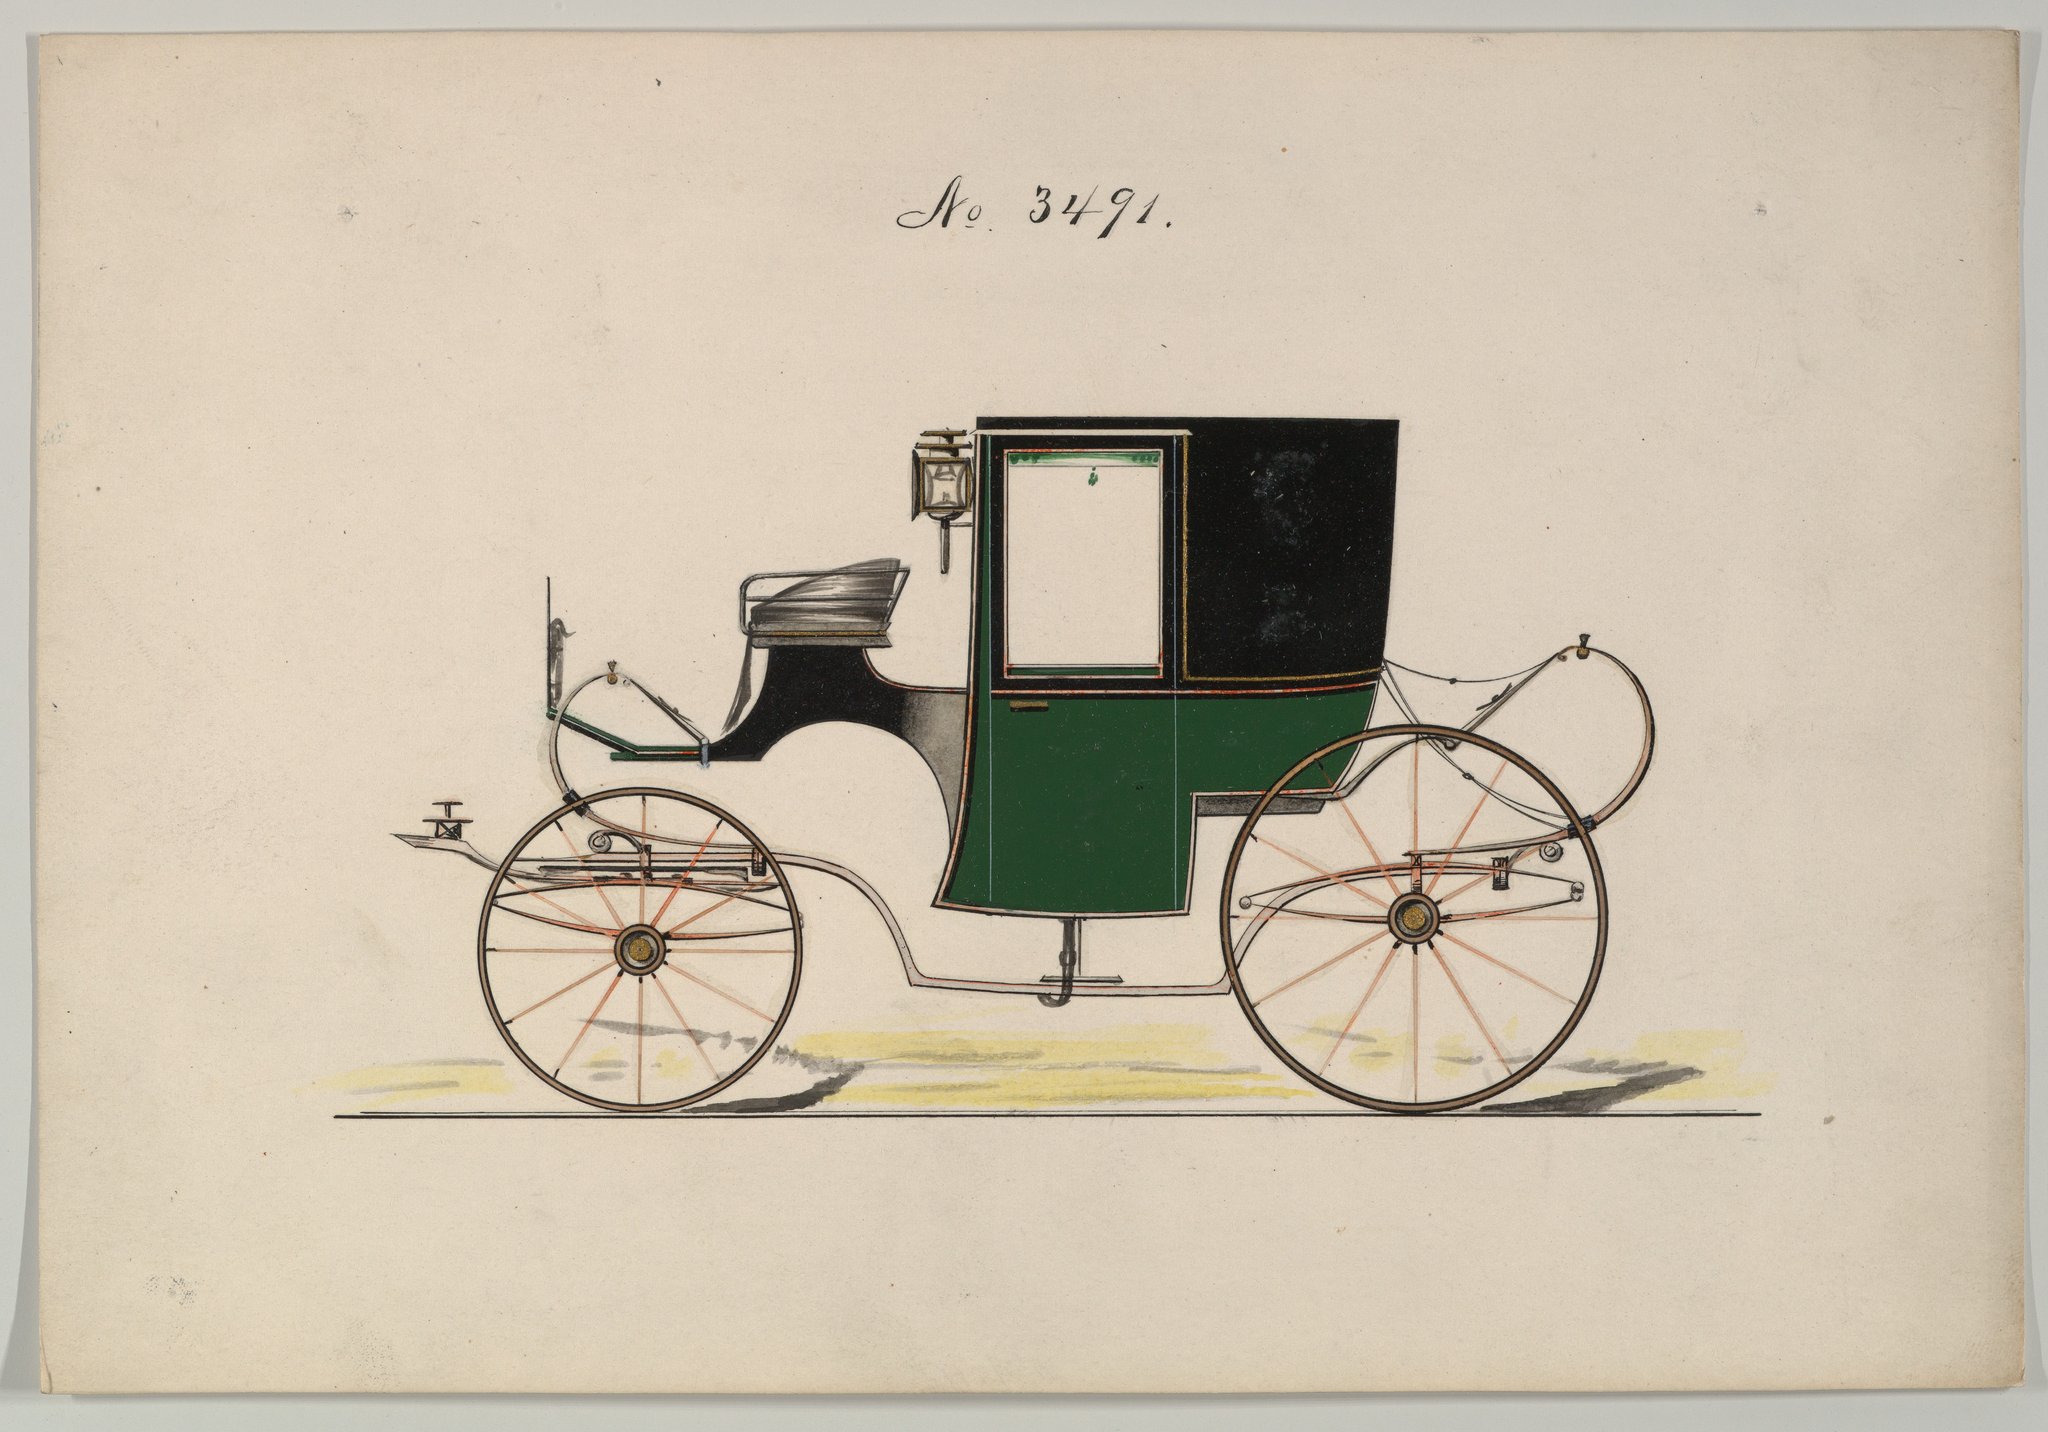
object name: drawing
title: Brougham #3491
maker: brewster & co.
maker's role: manufacturer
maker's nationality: american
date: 1879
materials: gouache, gum arabic, ink, watercolor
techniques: pen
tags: carriages